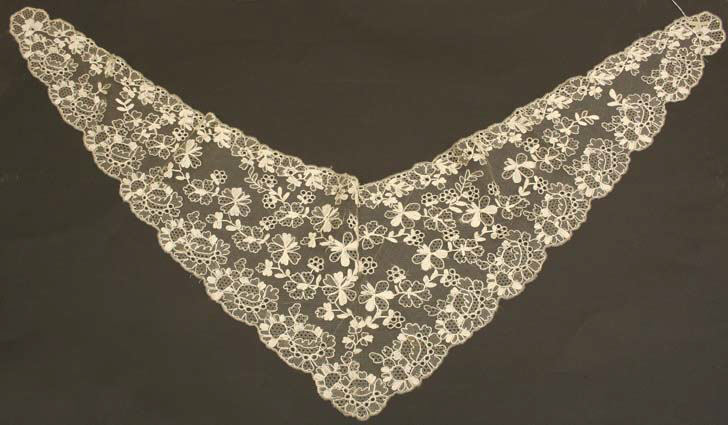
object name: fichu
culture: spanish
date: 1801-1900